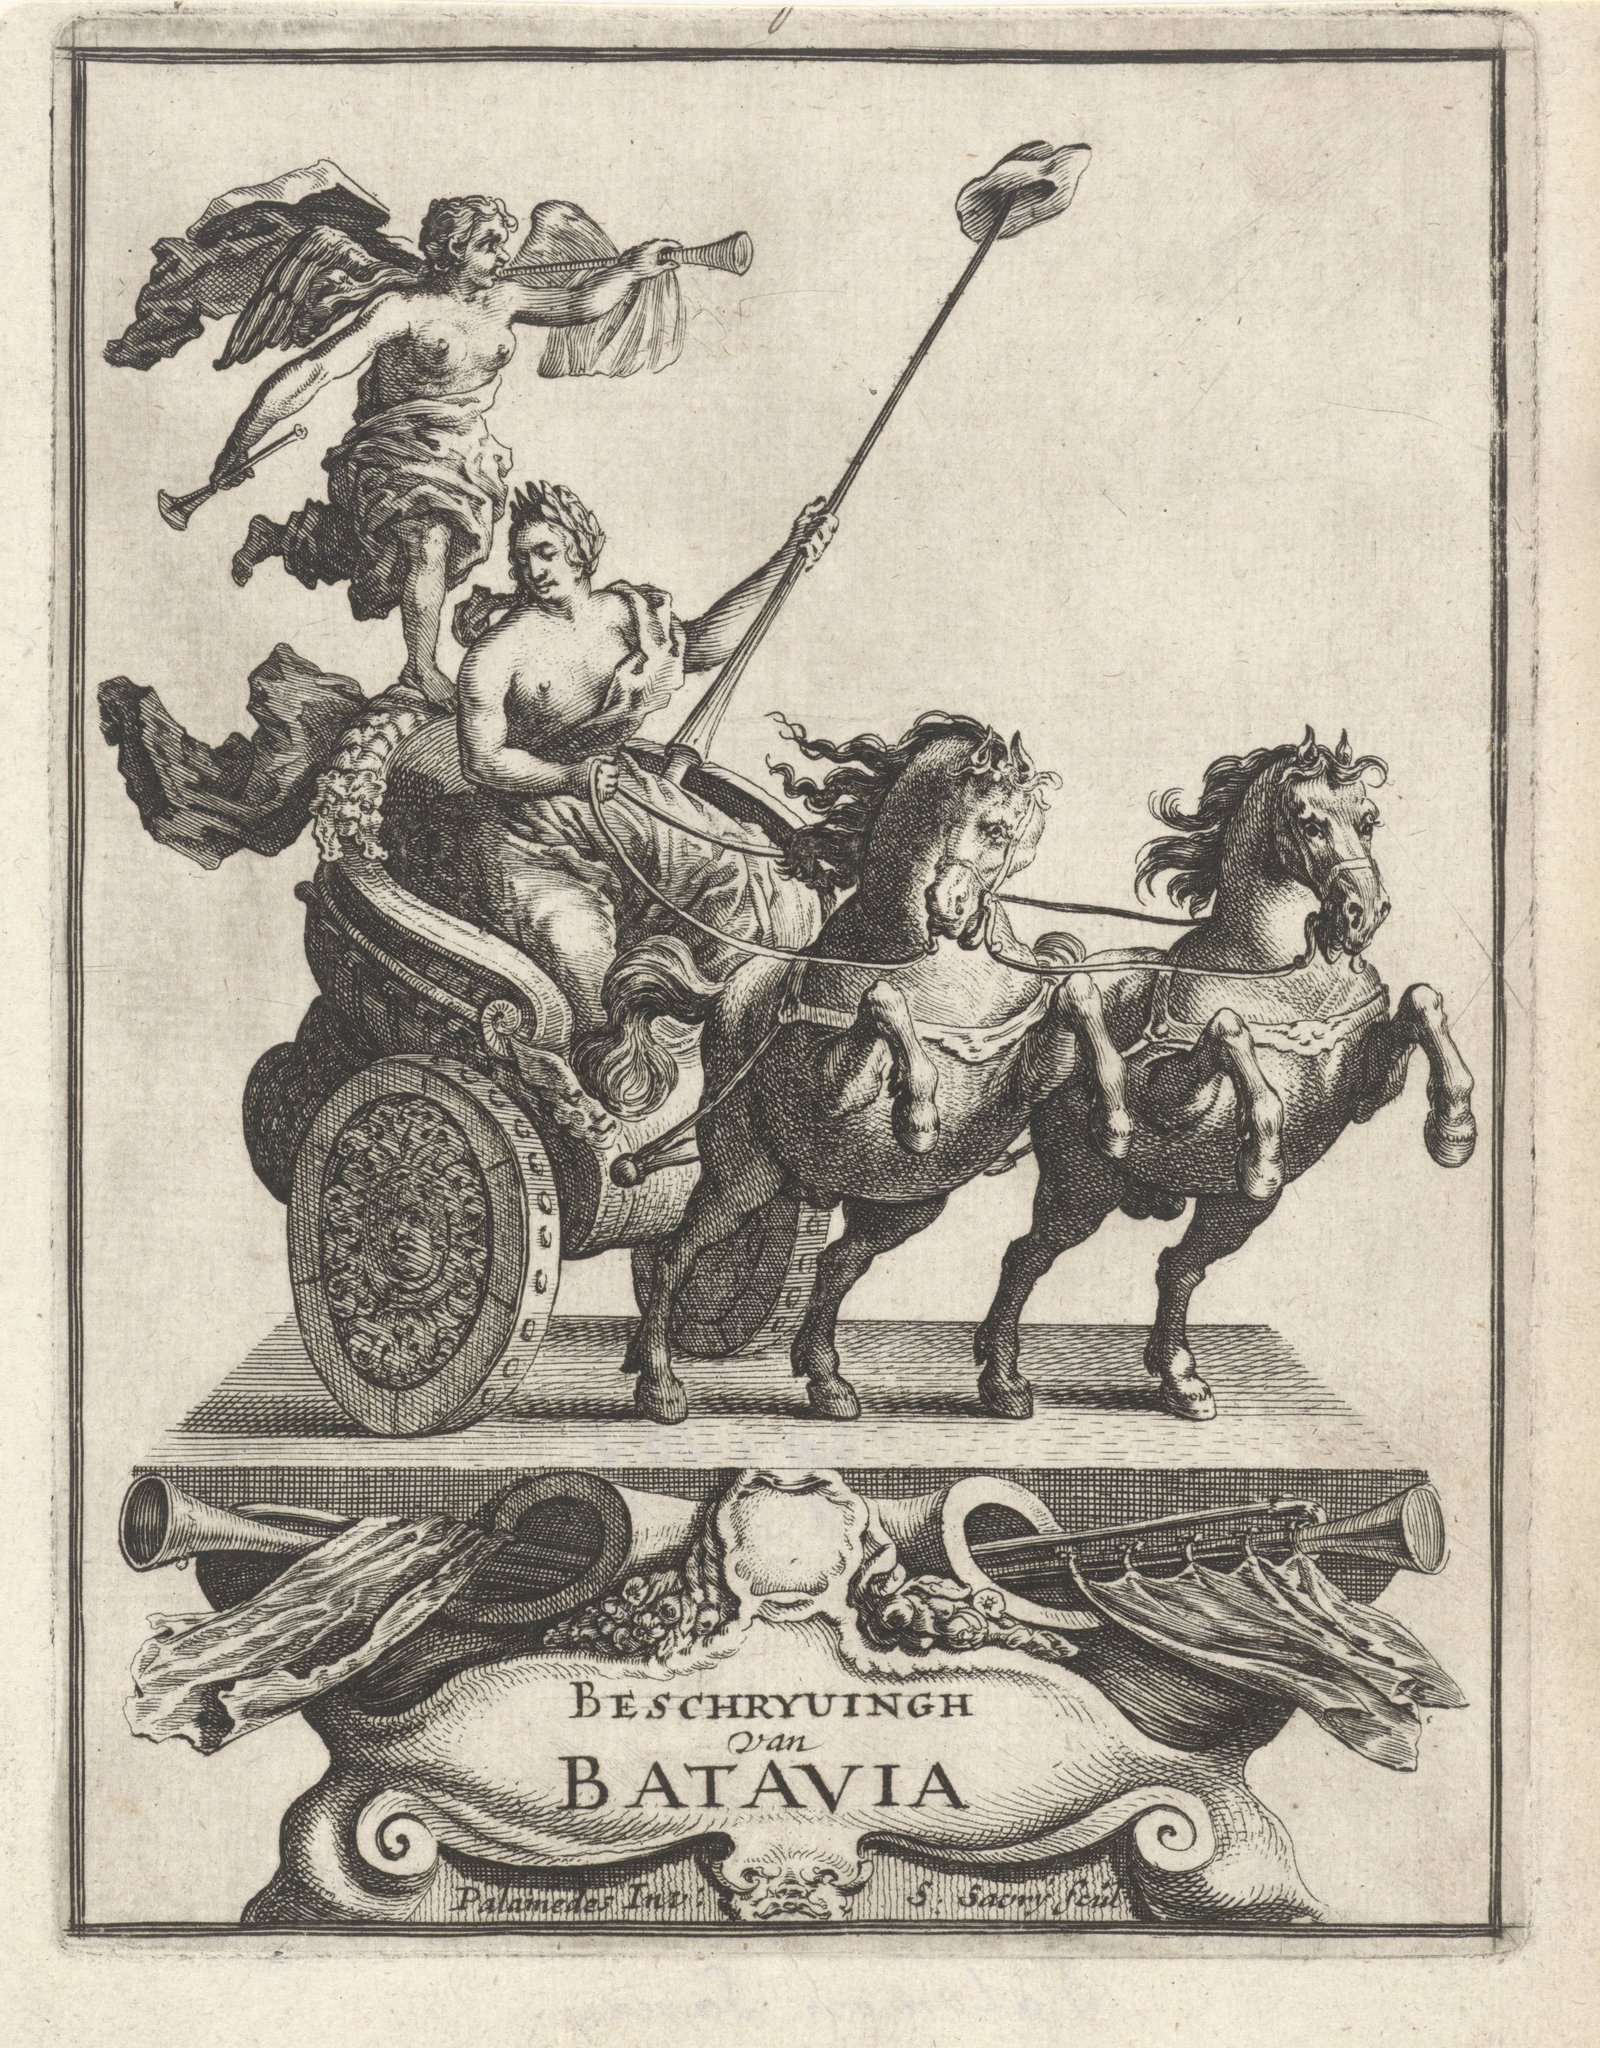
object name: titelblad, titelpagina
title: Batavia in een kar voortgetrokken door paarden en begeleid door de Faam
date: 1657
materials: paper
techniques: engraving, etching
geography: amsterdam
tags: personifications of countries, nations, states, districts, etc., chariot, triumphal car, fame; 'fama', 'fama buona', 'fama chiara' (ripa), batavia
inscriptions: collector's mark: Lugt 2166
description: Titelpagina voor: Someren, Johan van. Herstelde oudtheyt, ofte Beschrĳvinge van Batavia. Nijmegen: Andries van Hoogenhuysen, 1657.